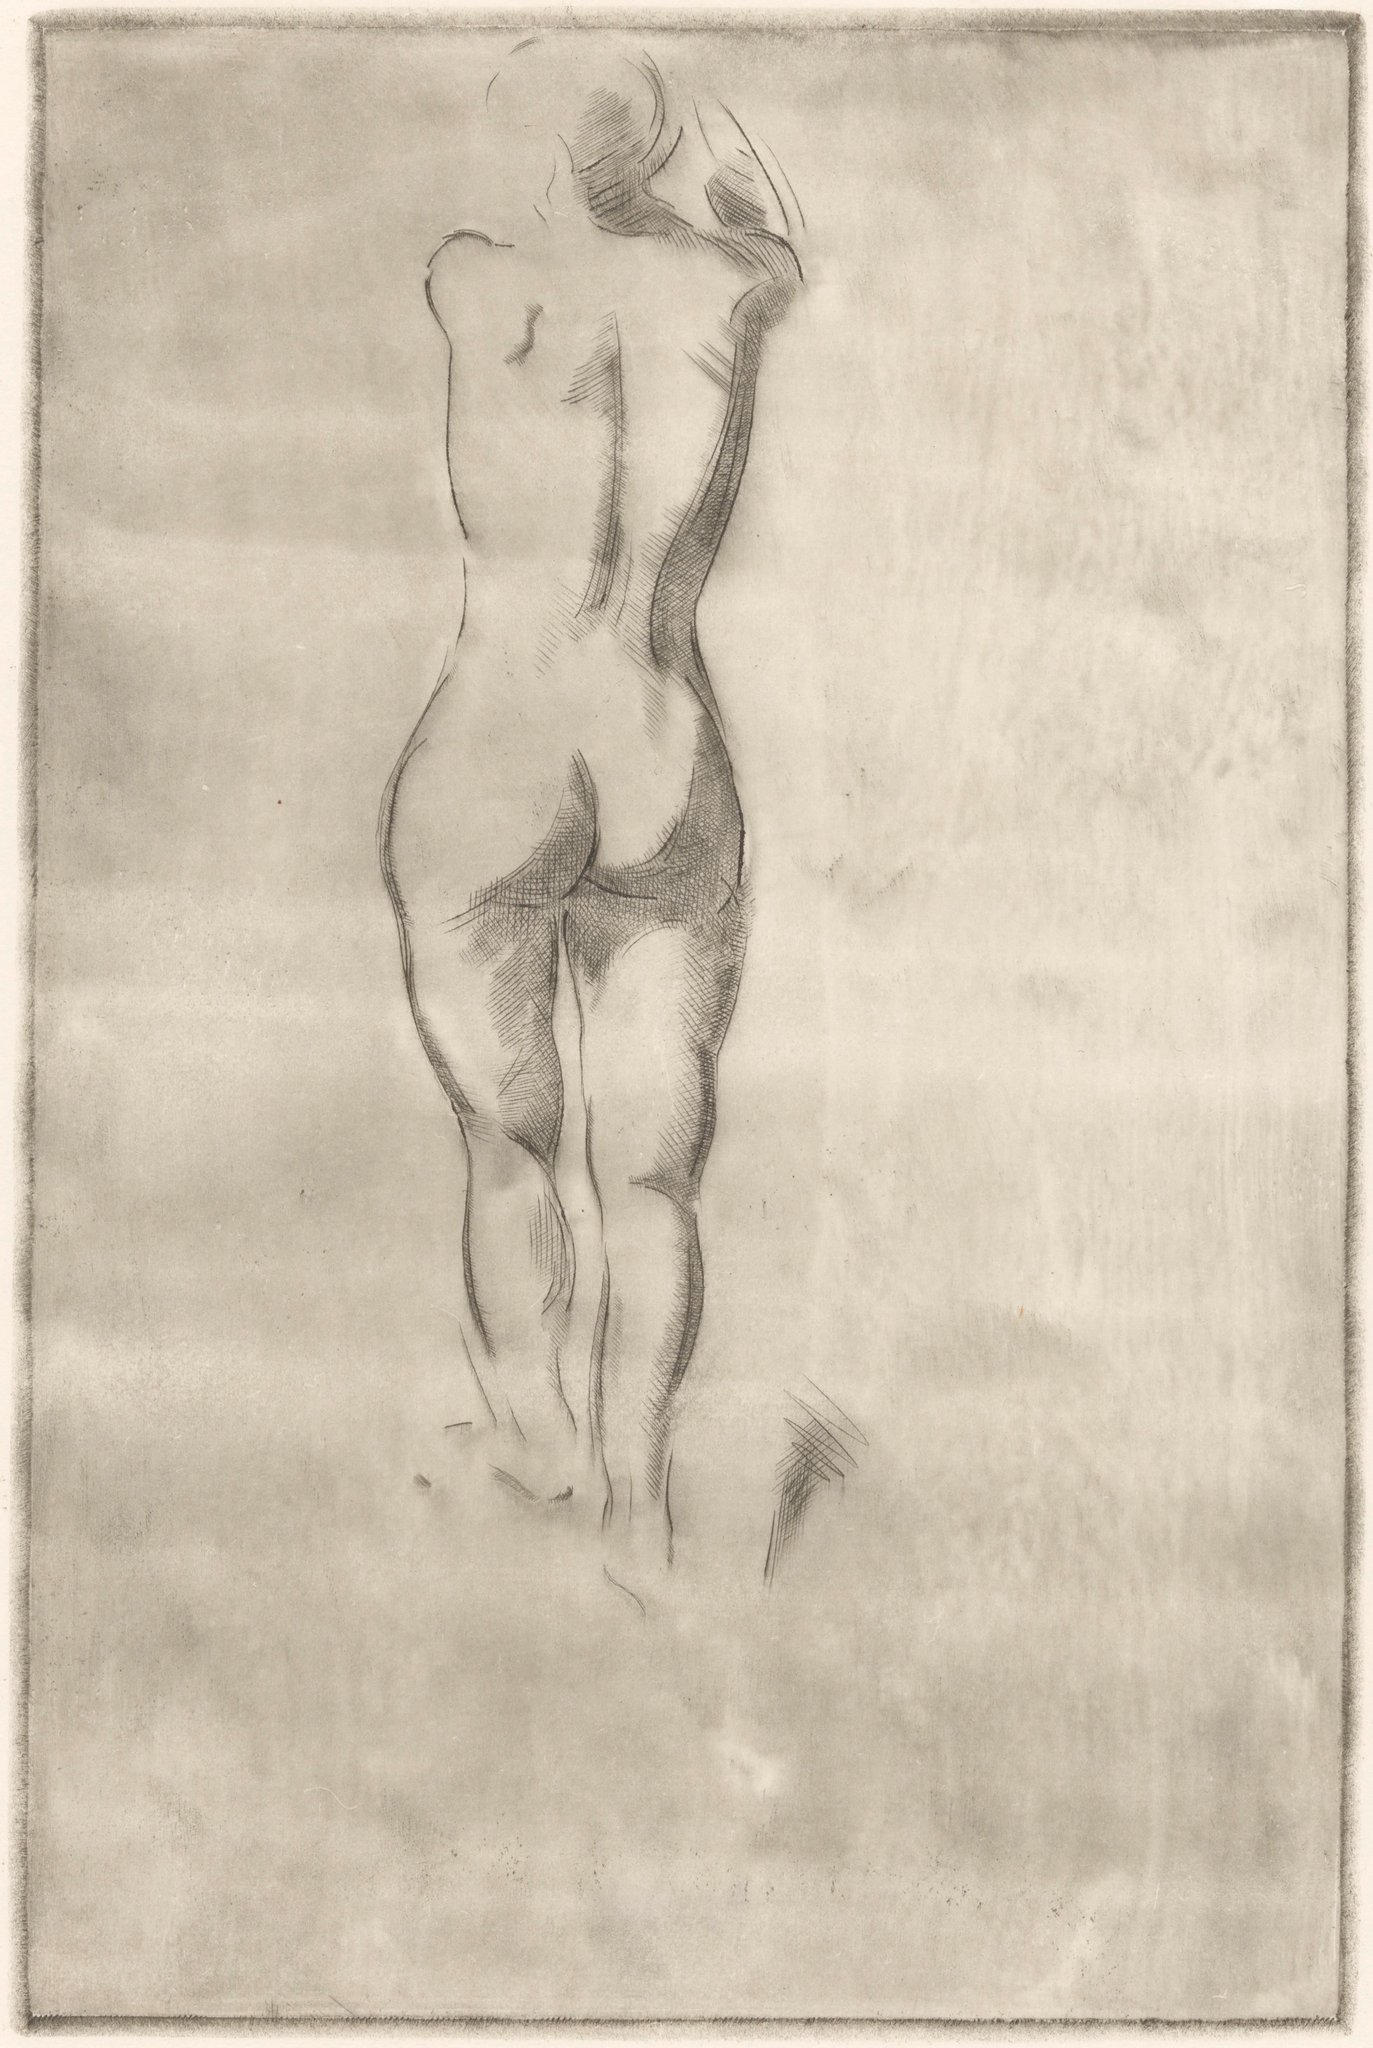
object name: print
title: Staande, naakte vrouw met opgeheven arm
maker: philippus de groot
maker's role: print maker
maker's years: 1826-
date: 1836-1931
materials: paper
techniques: etching, intaglio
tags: woman (showing herself) undressed, quasi-nude, standing figure - aa - female human figure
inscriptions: collector's mark: Lugt 2228